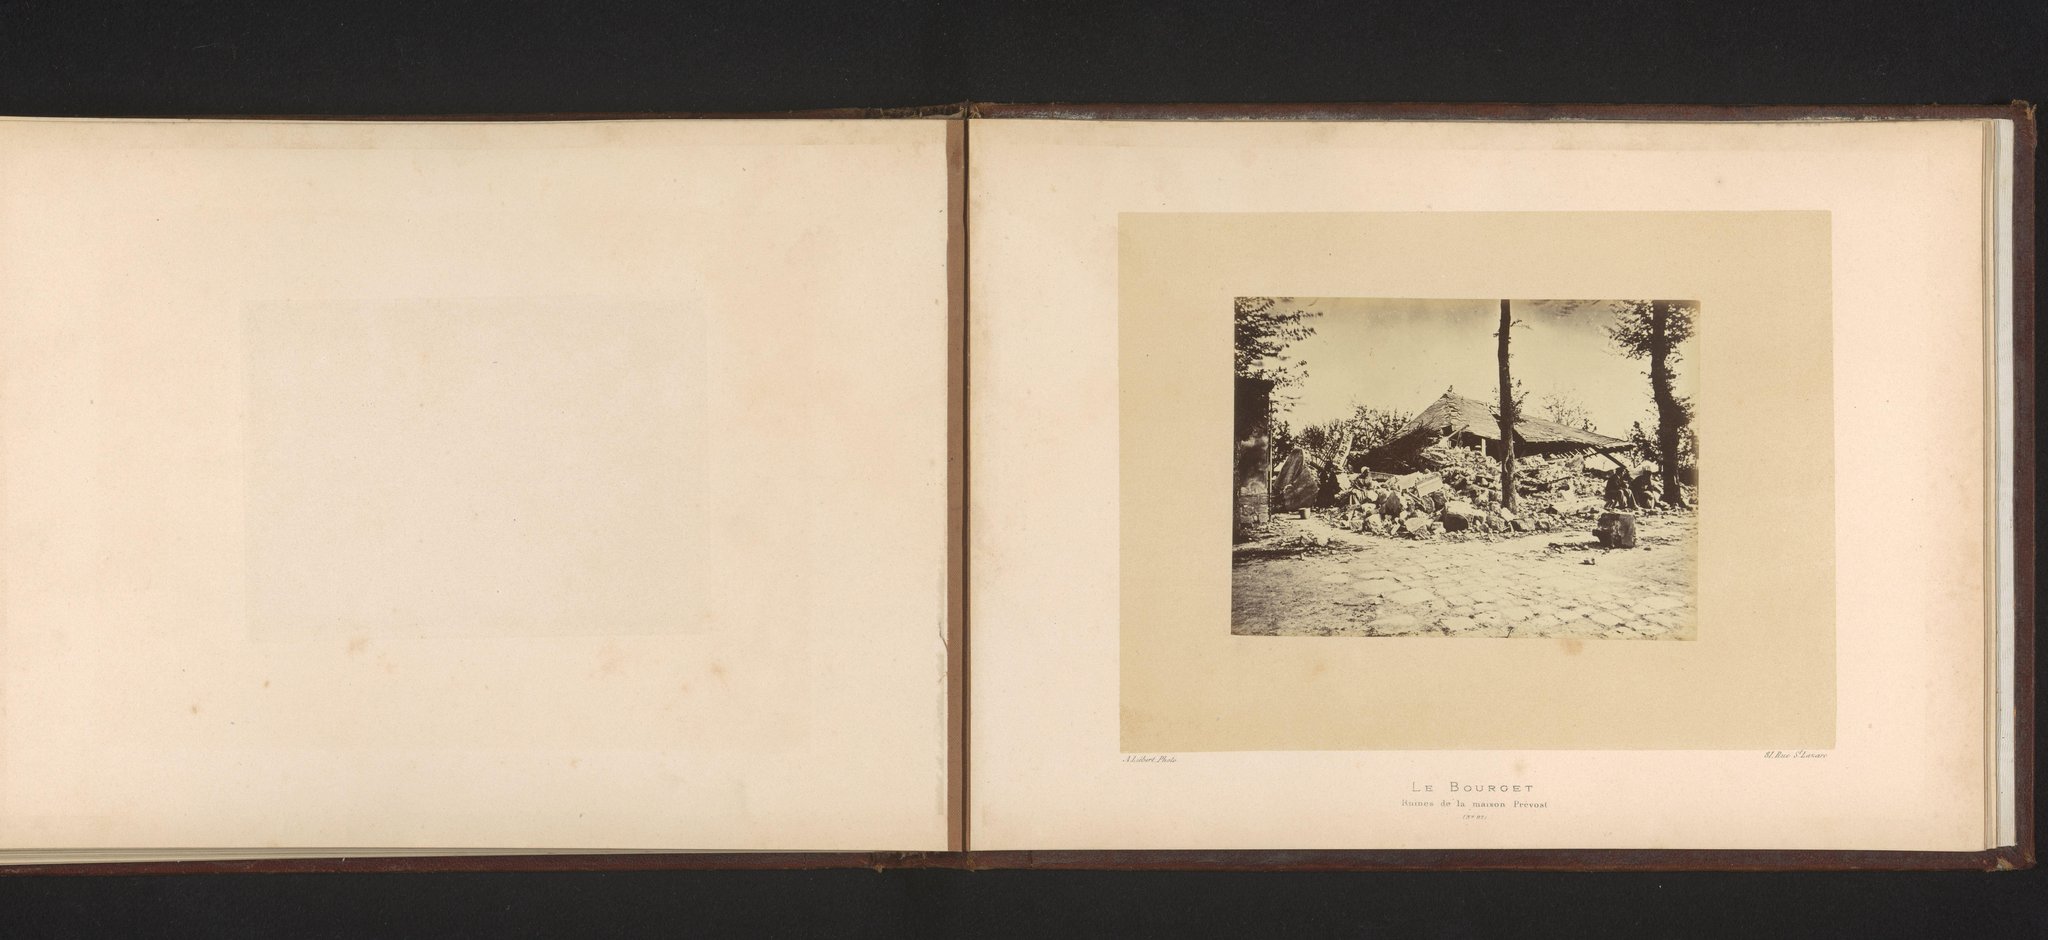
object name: photograph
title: Gezicht op de resten van Maison Prévost in Le Bourget na de verwoesting door de Commune van Parijs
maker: alphonse-justin liébert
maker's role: fotograaf, marinier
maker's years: 1827-1914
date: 1871-1872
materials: photographic support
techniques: albumen print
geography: le bourget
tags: ruin of a building ~ architecture, civic architecture; edifices; dwellings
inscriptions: address: ‘31, Rue St. Lazare’, number: ‘(No. 97)’